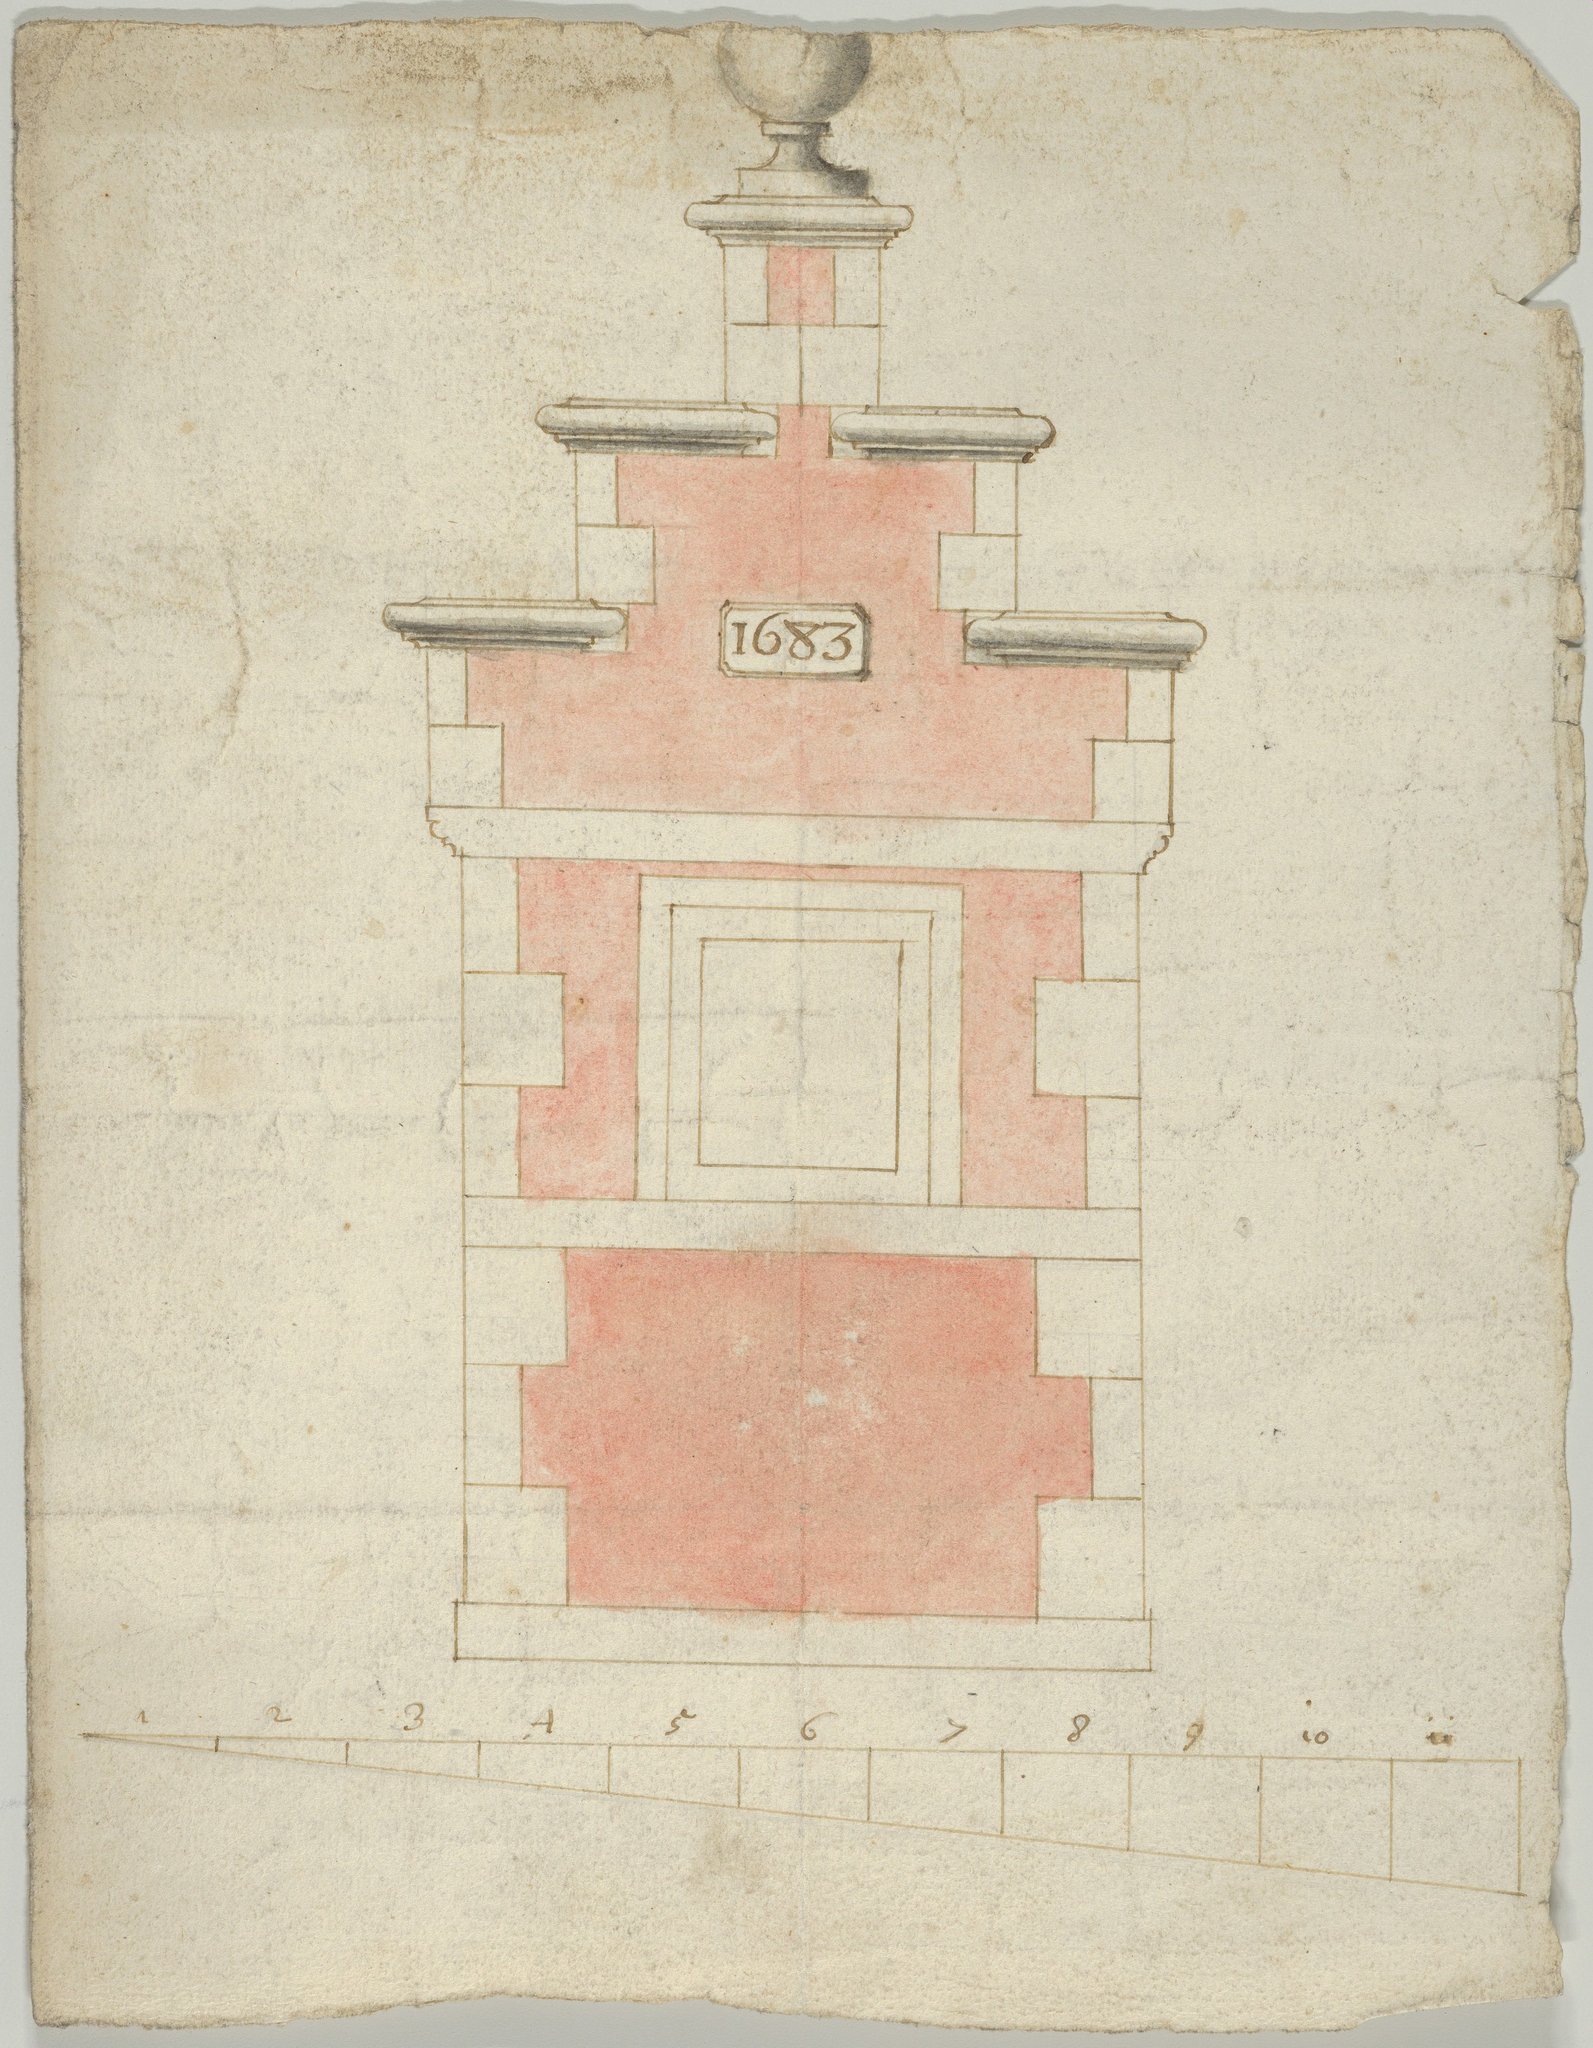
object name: drawing ornament architecture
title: Design for a Small Tower or Stepped Gable, dated 1683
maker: anonymous, flemish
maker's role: artist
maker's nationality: flemish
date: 1683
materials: ink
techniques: pen, wash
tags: architecture